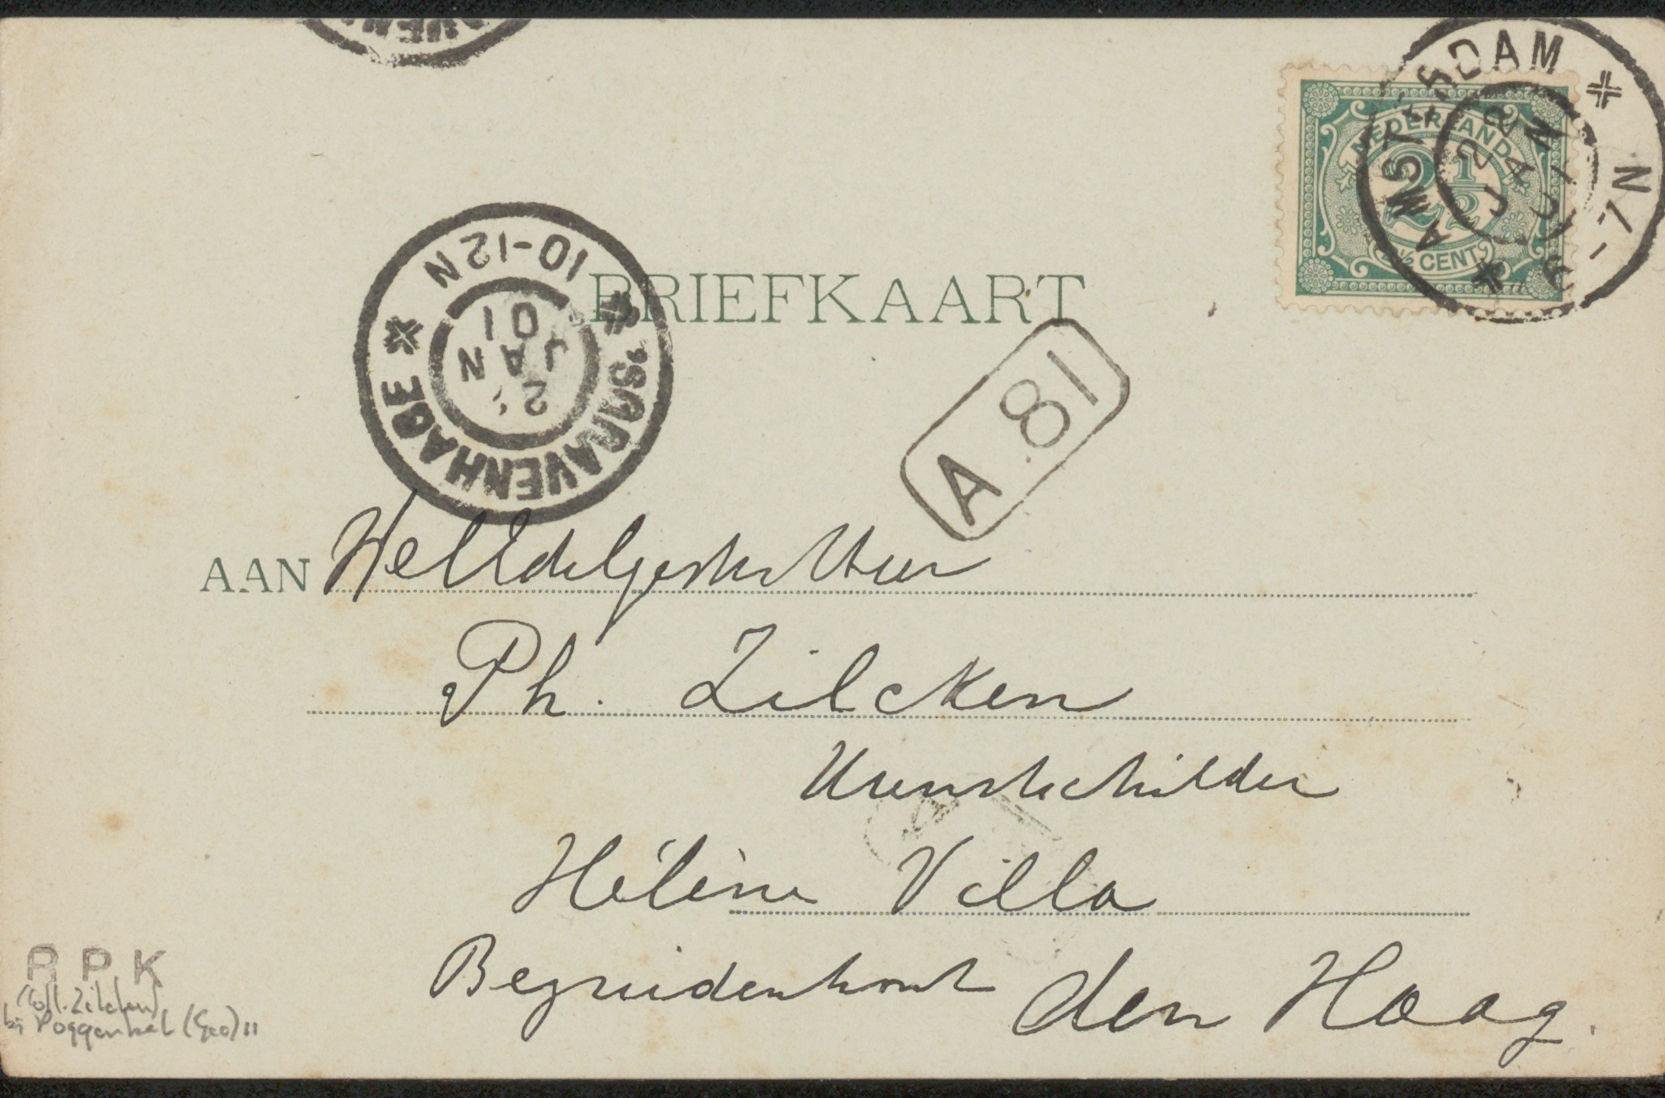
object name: postcard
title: Briefkaart aan Philip Zilcken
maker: geo poggenbeek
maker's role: draughtsman, painter, print maker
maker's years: 1853-1903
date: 1901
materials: cardboard, ink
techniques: pen, writing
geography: amsterdam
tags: the hague, philip zilcken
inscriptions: collector's mark: ‘RPK’